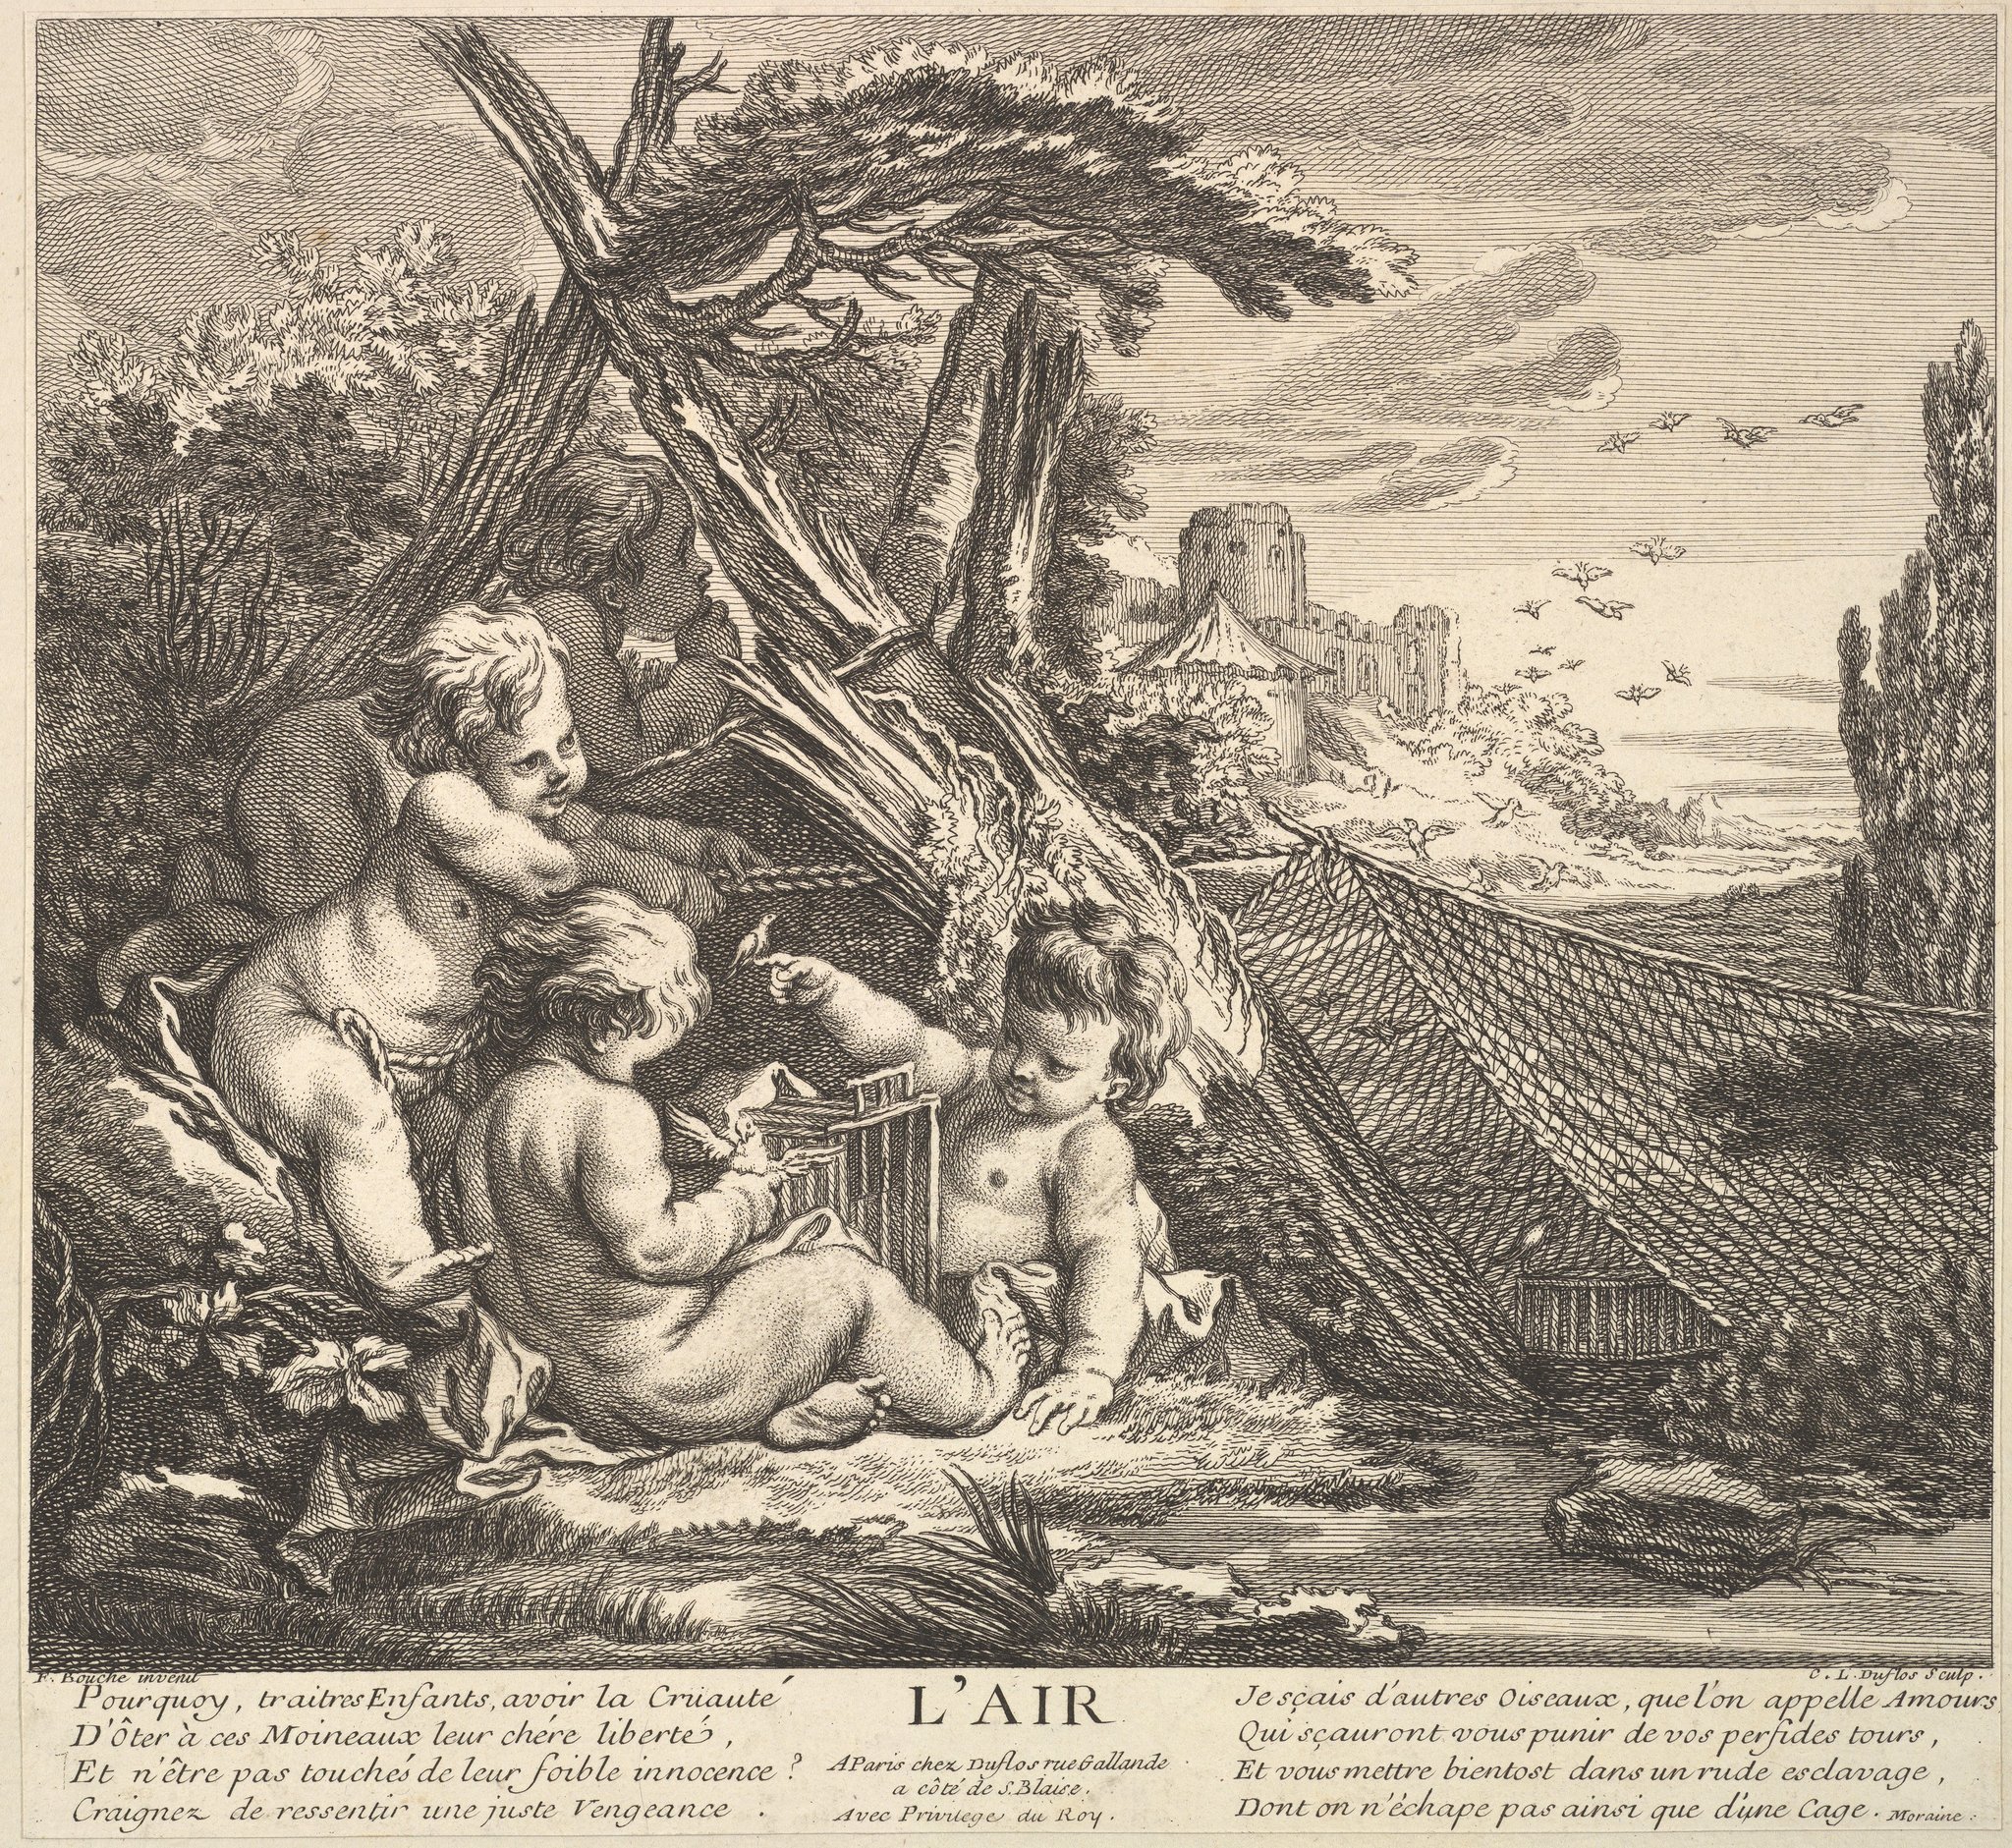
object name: print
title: Air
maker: claude augustin duflos le jeune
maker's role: artist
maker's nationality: french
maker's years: 1700-1786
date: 1701-1800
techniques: engraving, etching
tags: birds,children